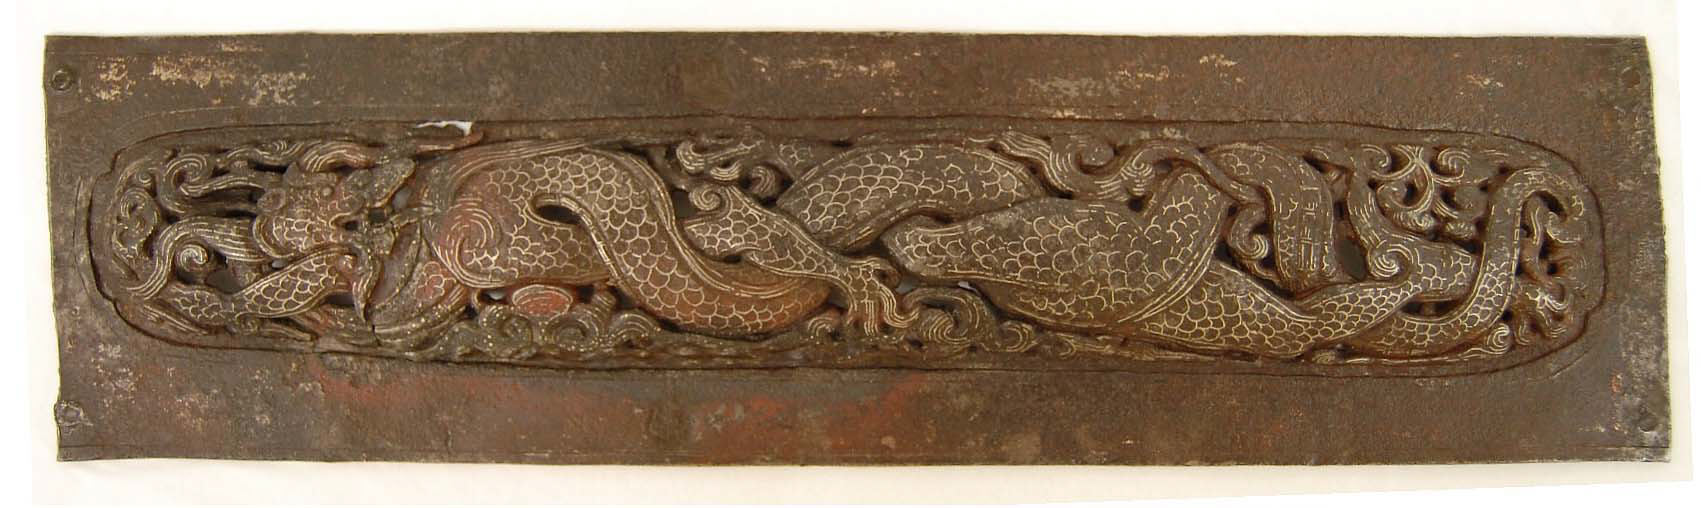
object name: plaque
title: Pair of Plaques with Dragons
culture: tibetan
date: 1401-1600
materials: iron, silver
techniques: embossing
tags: dragons